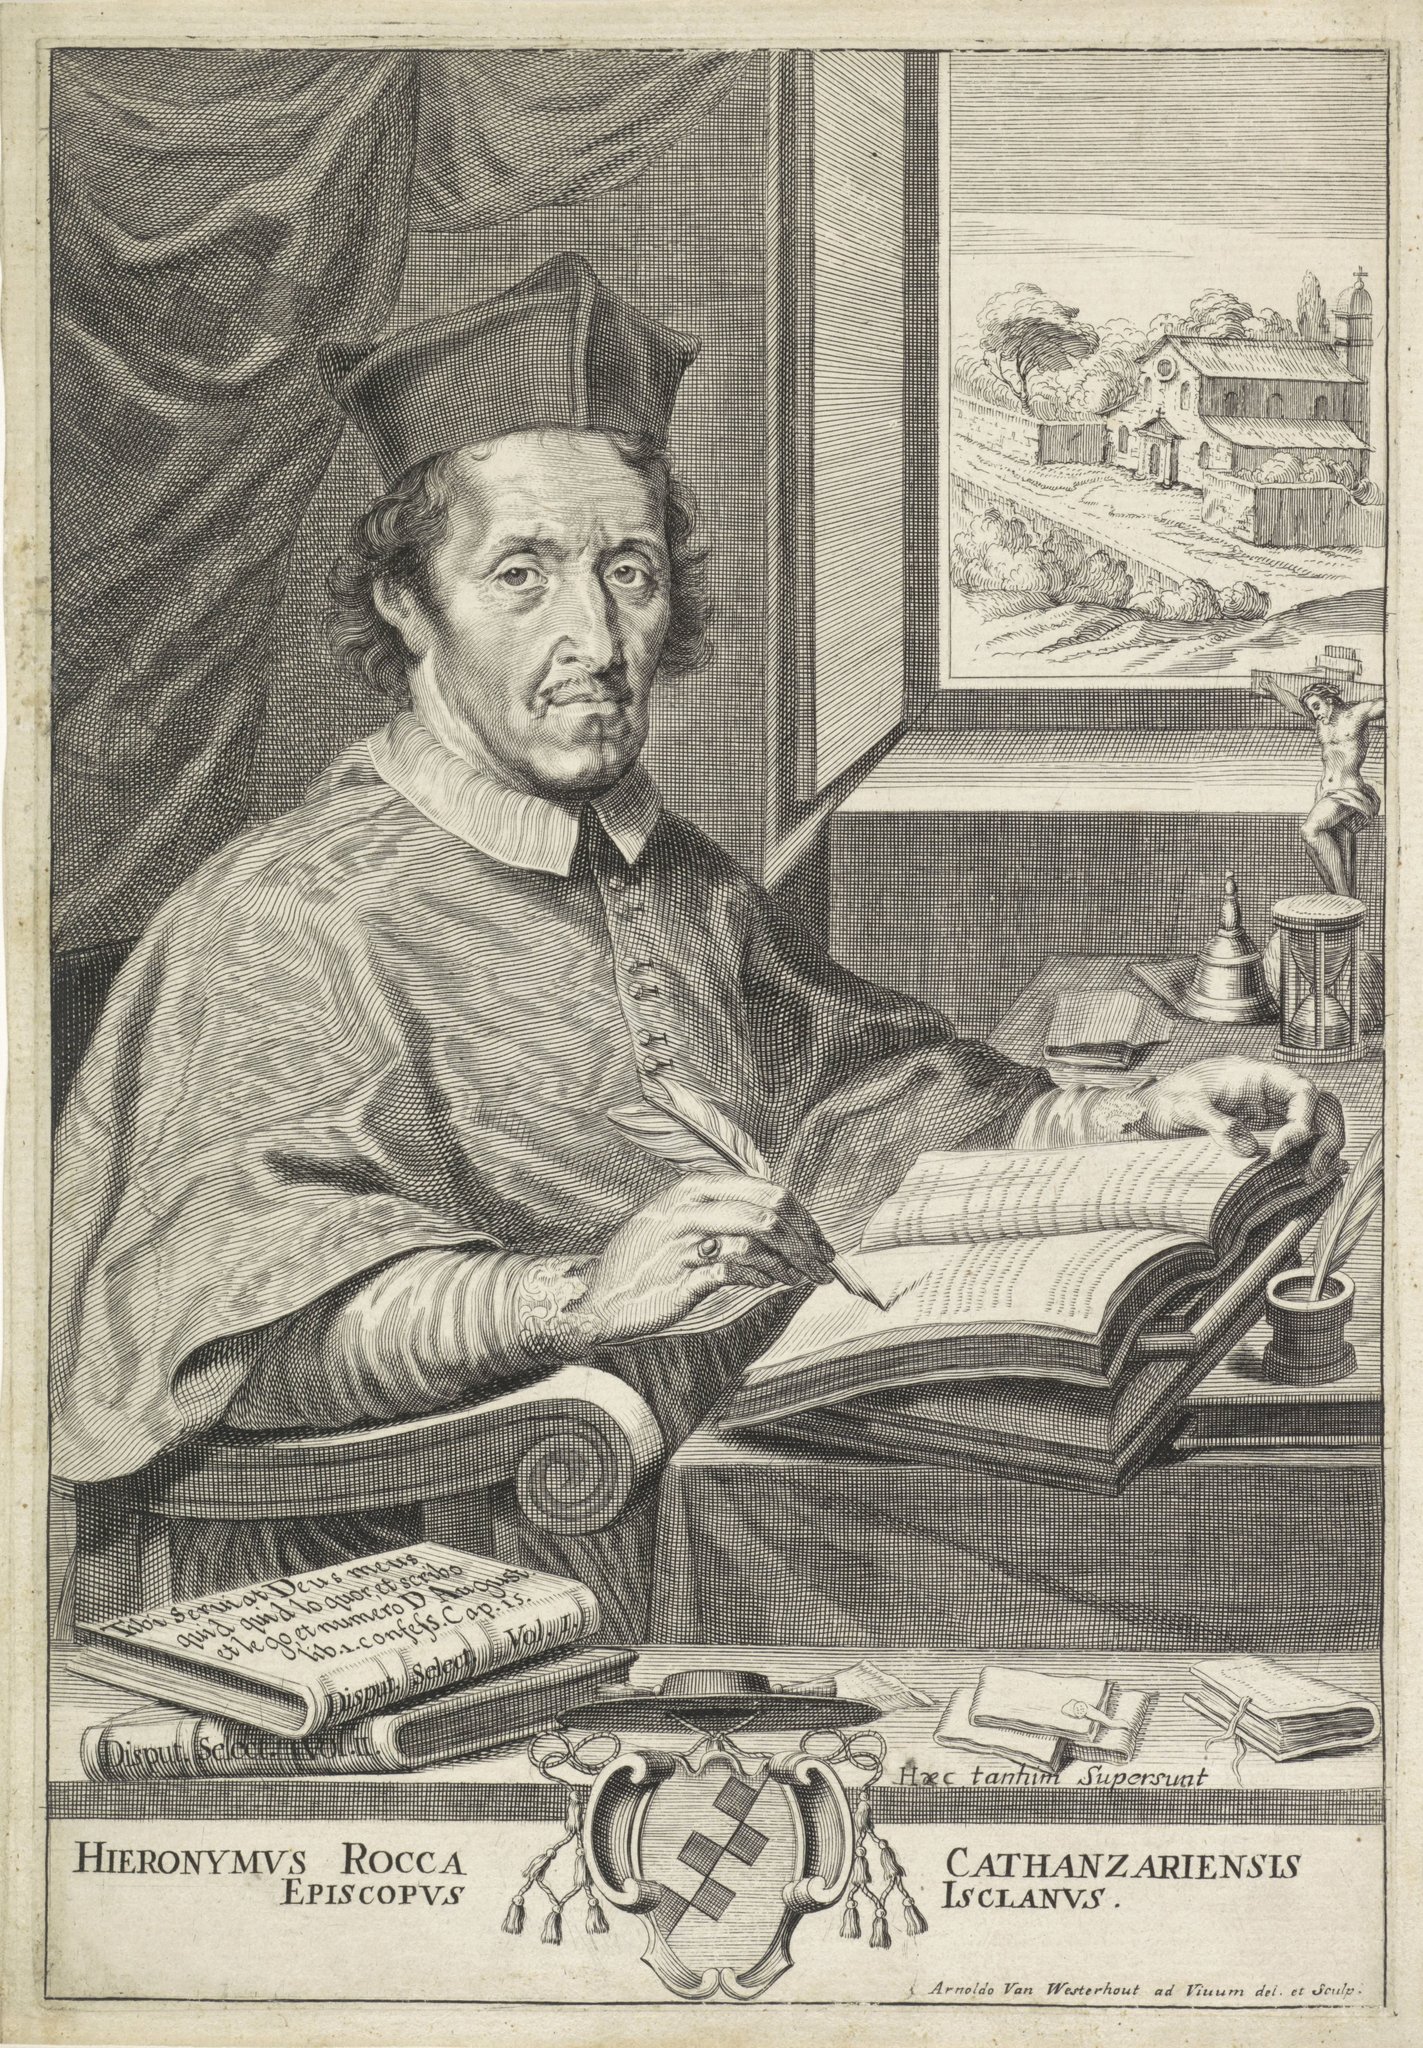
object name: print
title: Portret van Hieronymus Rocca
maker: arnold van westerhout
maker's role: print maker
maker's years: 1651-1725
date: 1665-1725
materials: paper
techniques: engraving, etching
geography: italy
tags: church (exterior), hourglass, crucifix ~ personal devotion, armorial bearing, heraldry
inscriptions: collector's mark: Lugt 2228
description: Portret van Hieronymus Rocca, bisschop van Ischia. Hij zit in zijn studeervertrek aan een schrijftafel. Op de tafel een zandloper, crucifix, bel en een schrijfveer. Op de voorgrond boeken en notitieboekjes. Op de achtergrond door het venster een gezicht op een kerk. In de marge zijn naam en wapenschild.